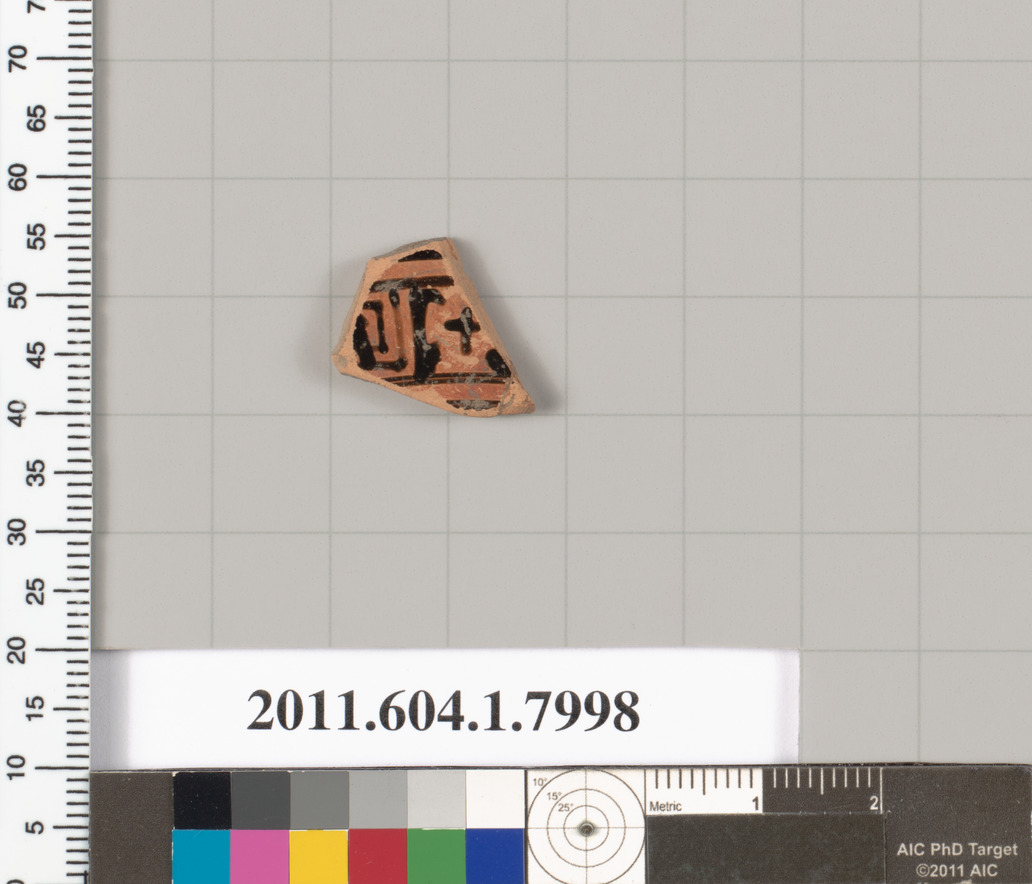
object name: kylix fragment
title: Terracotta fragment of a kylix (drinking cup)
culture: greek, attic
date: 460-450 BCE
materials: terracotta